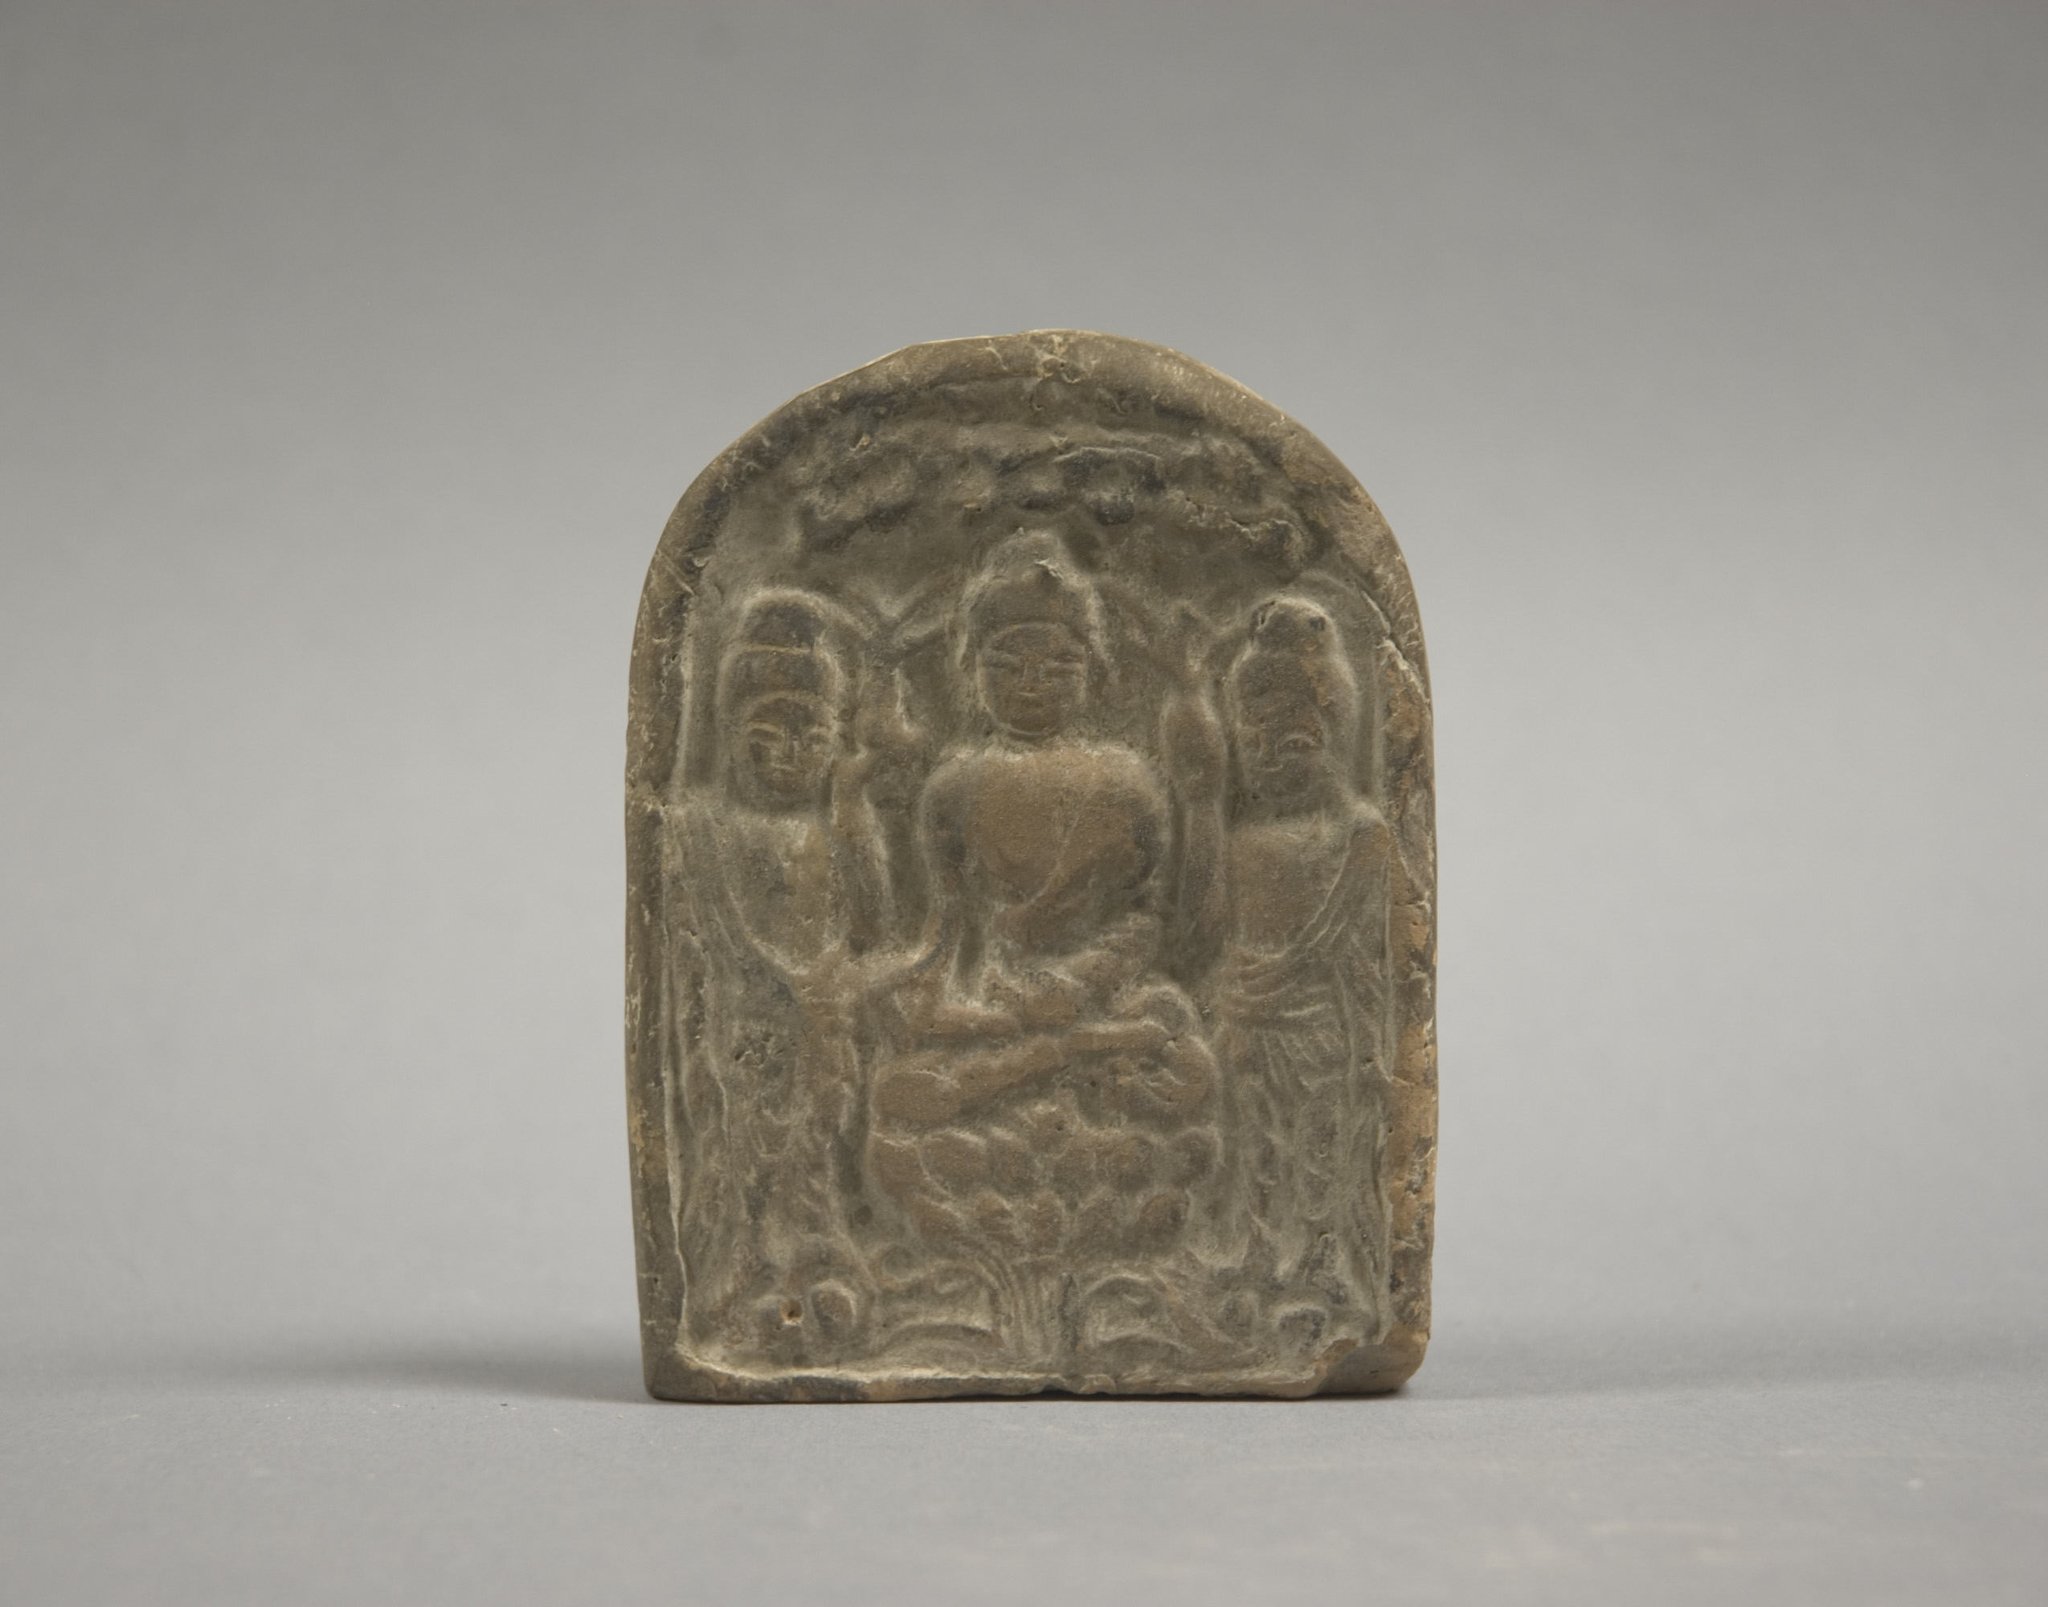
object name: votive tablet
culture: chinese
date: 618-907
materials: terracotta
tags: buddhism,bodhisattvas,buddha